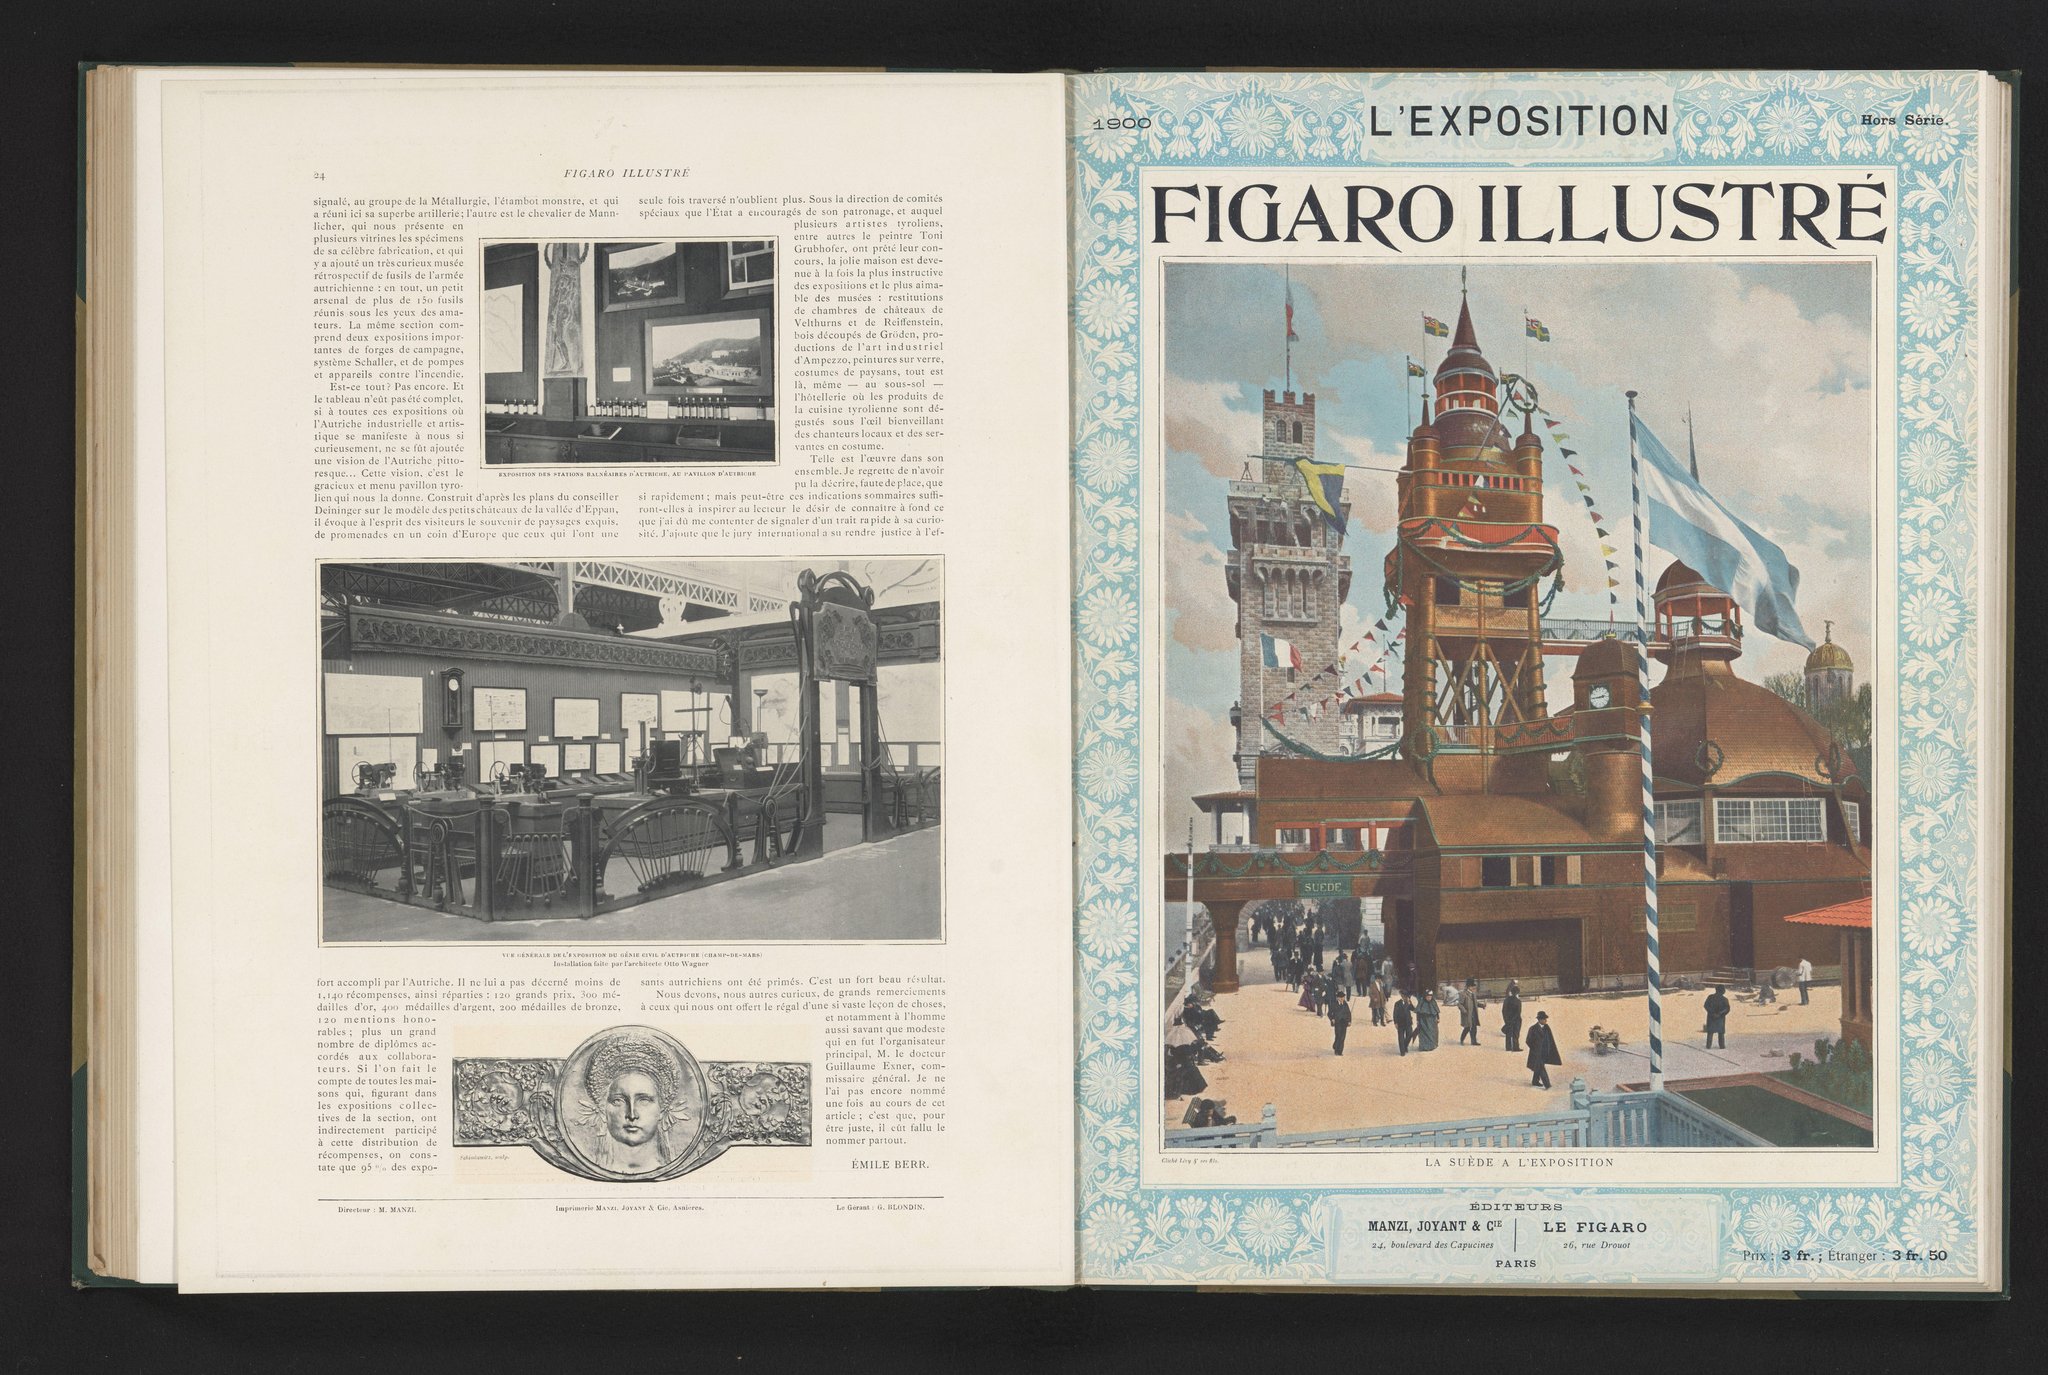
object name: page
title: La Suède a l'exposition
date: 1885-1901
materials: paper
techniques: four-color autotype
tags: world fair, world exhibition